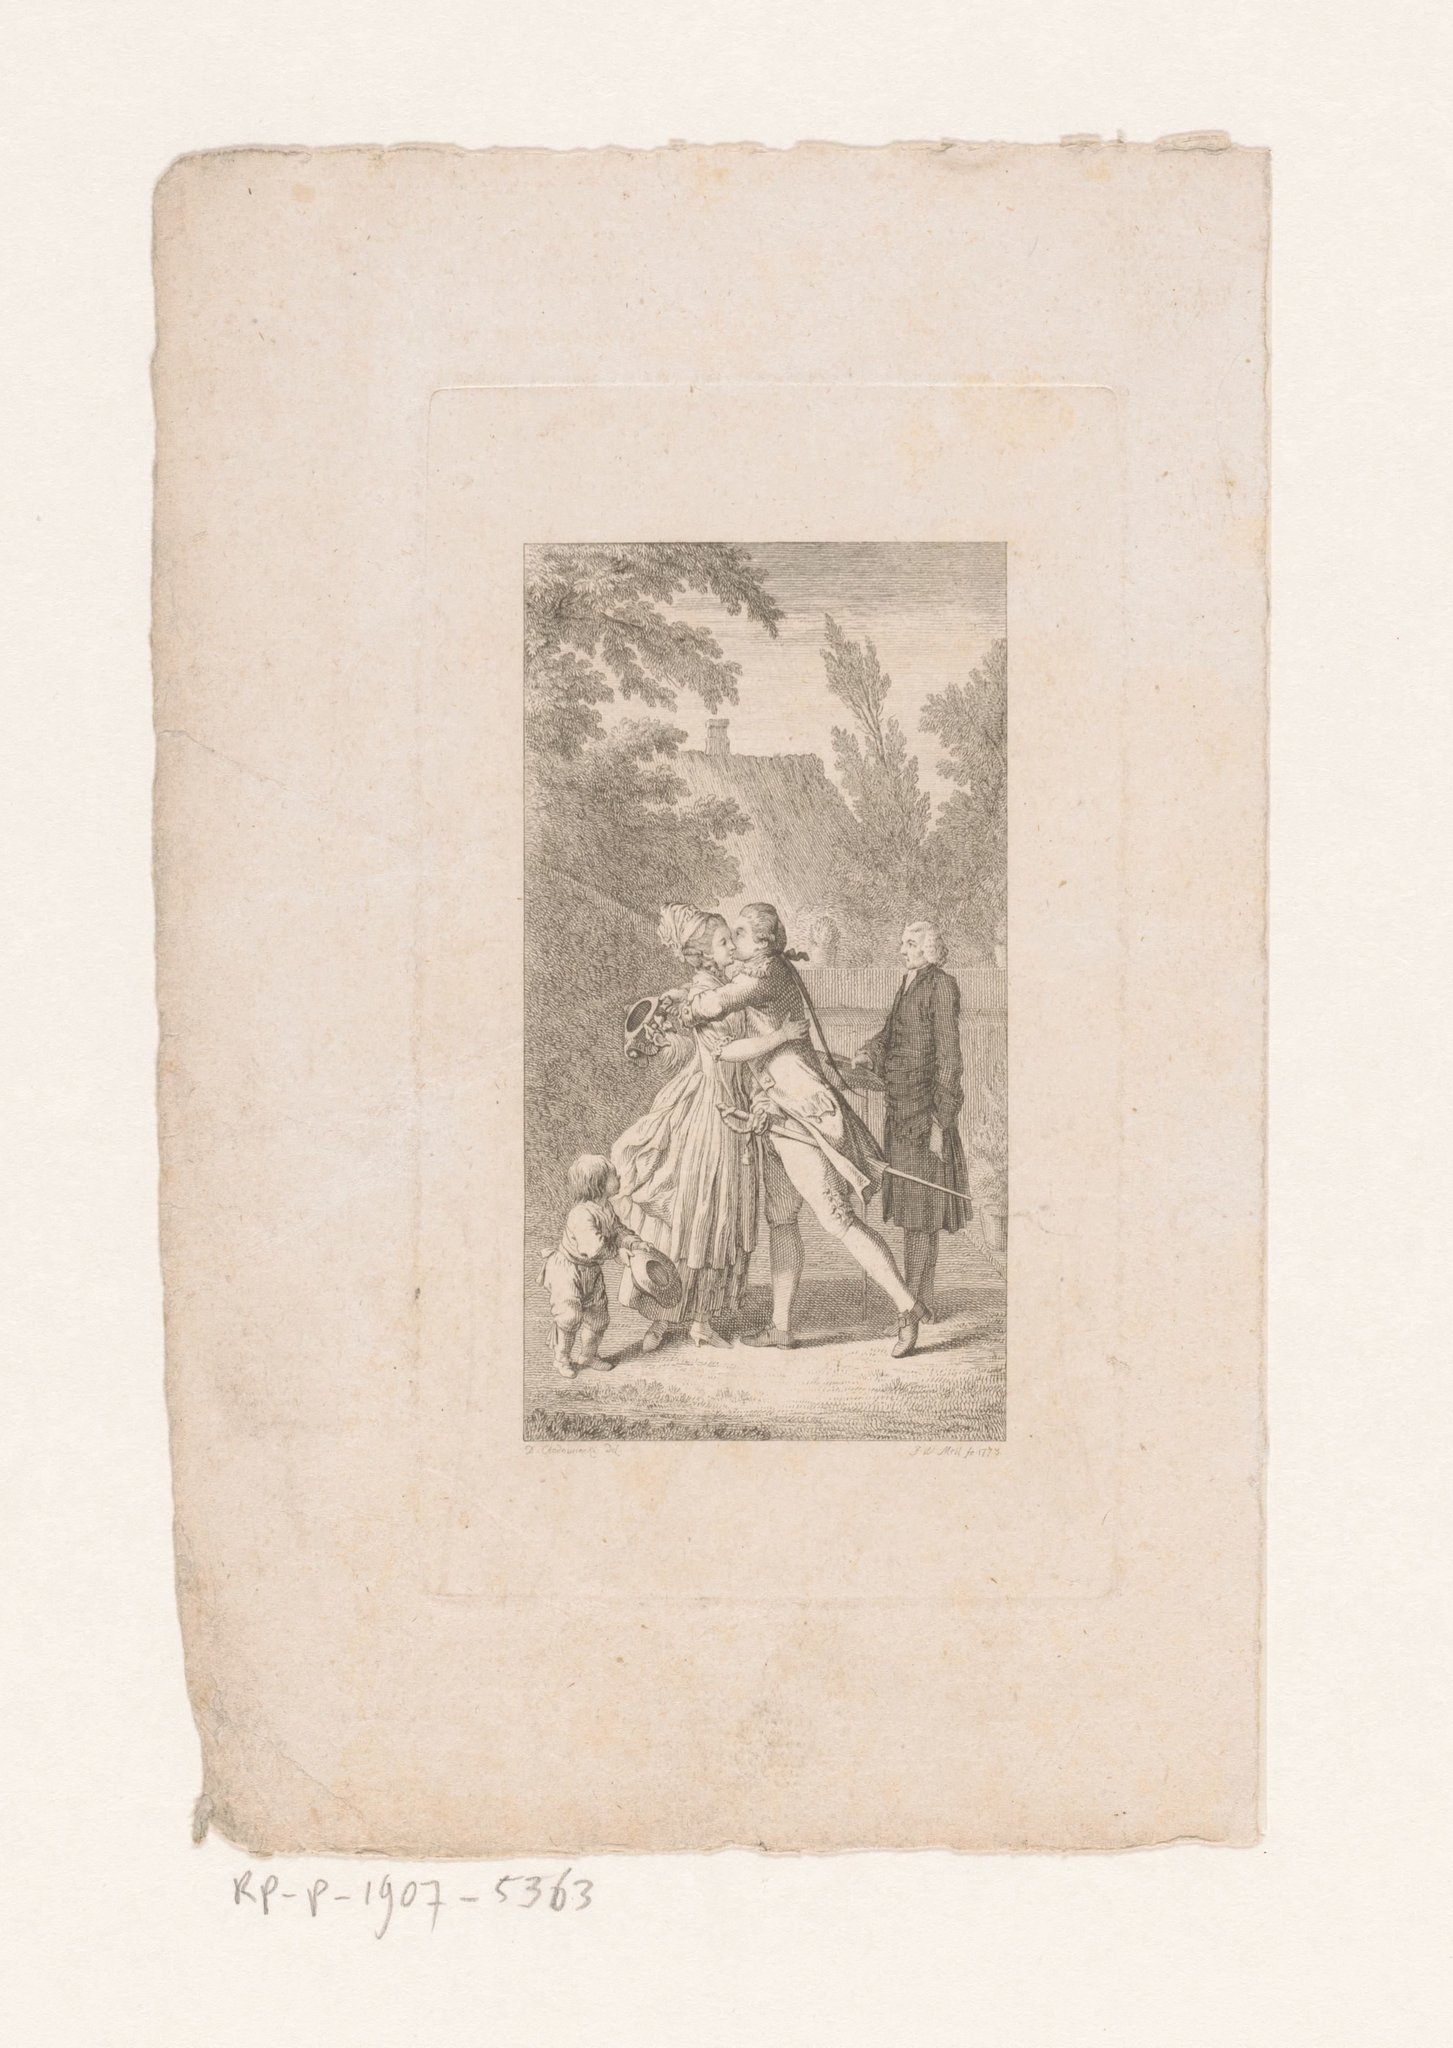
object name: print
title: Teruggekeerde soldaat omarmt zijn vrouw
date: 1773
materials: paper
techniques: etching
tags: return of the soldiers to civilian life, returning home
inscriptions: collector's mark: Lugt 2228